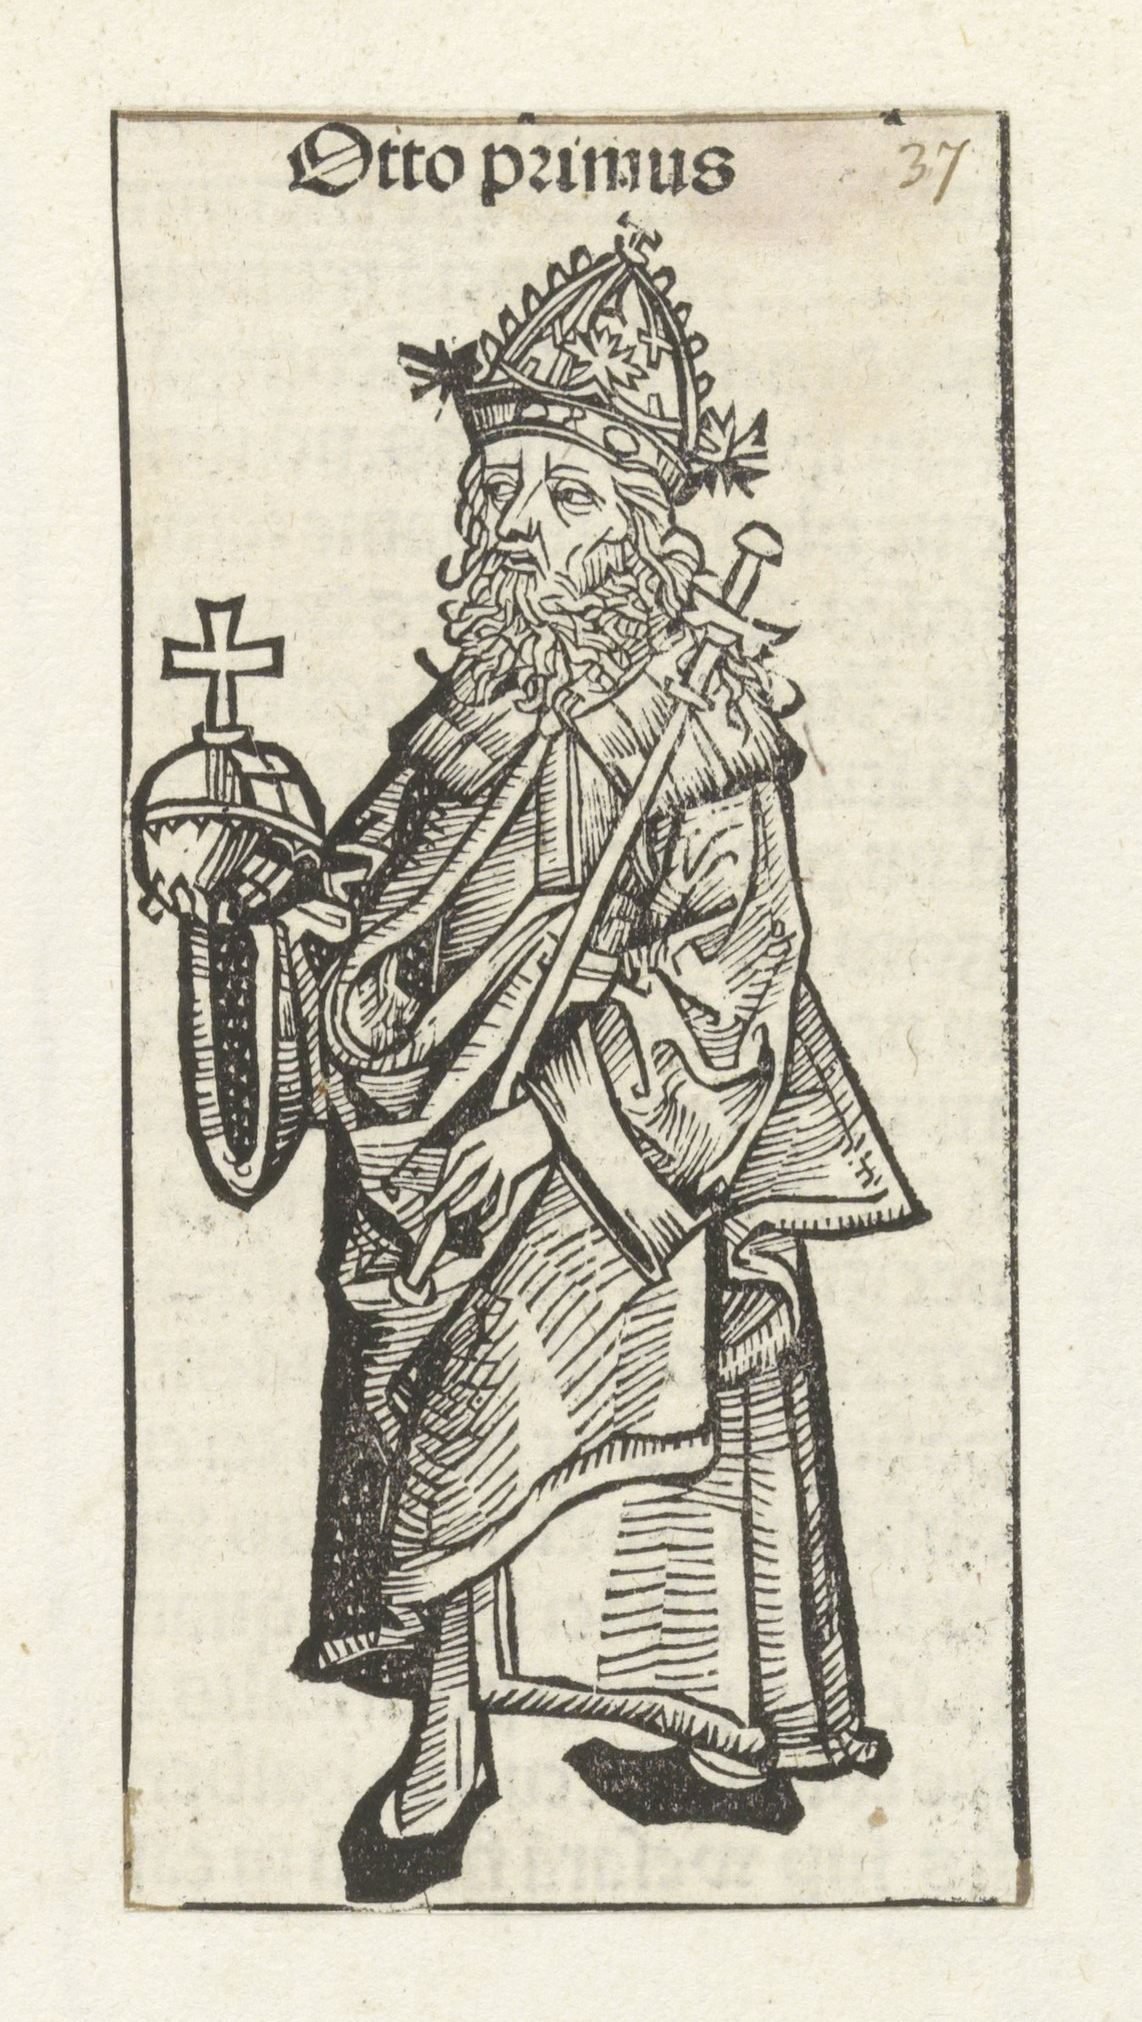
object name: book illustration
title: Keizer Otto I de Grote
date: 1493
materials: paper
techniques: letterpress printing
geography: nuremberg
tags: emperor, king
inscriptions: inscription: ‘37’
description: Een koning met rijksappel en scepter, ten voeten uit. De voorstelling is onderdeel van de opeenvolging keizers in de Liber Chronicarum. De tekst identificeert de man als keizer Otto I de Grote. De prent maakt deel uit van een album.